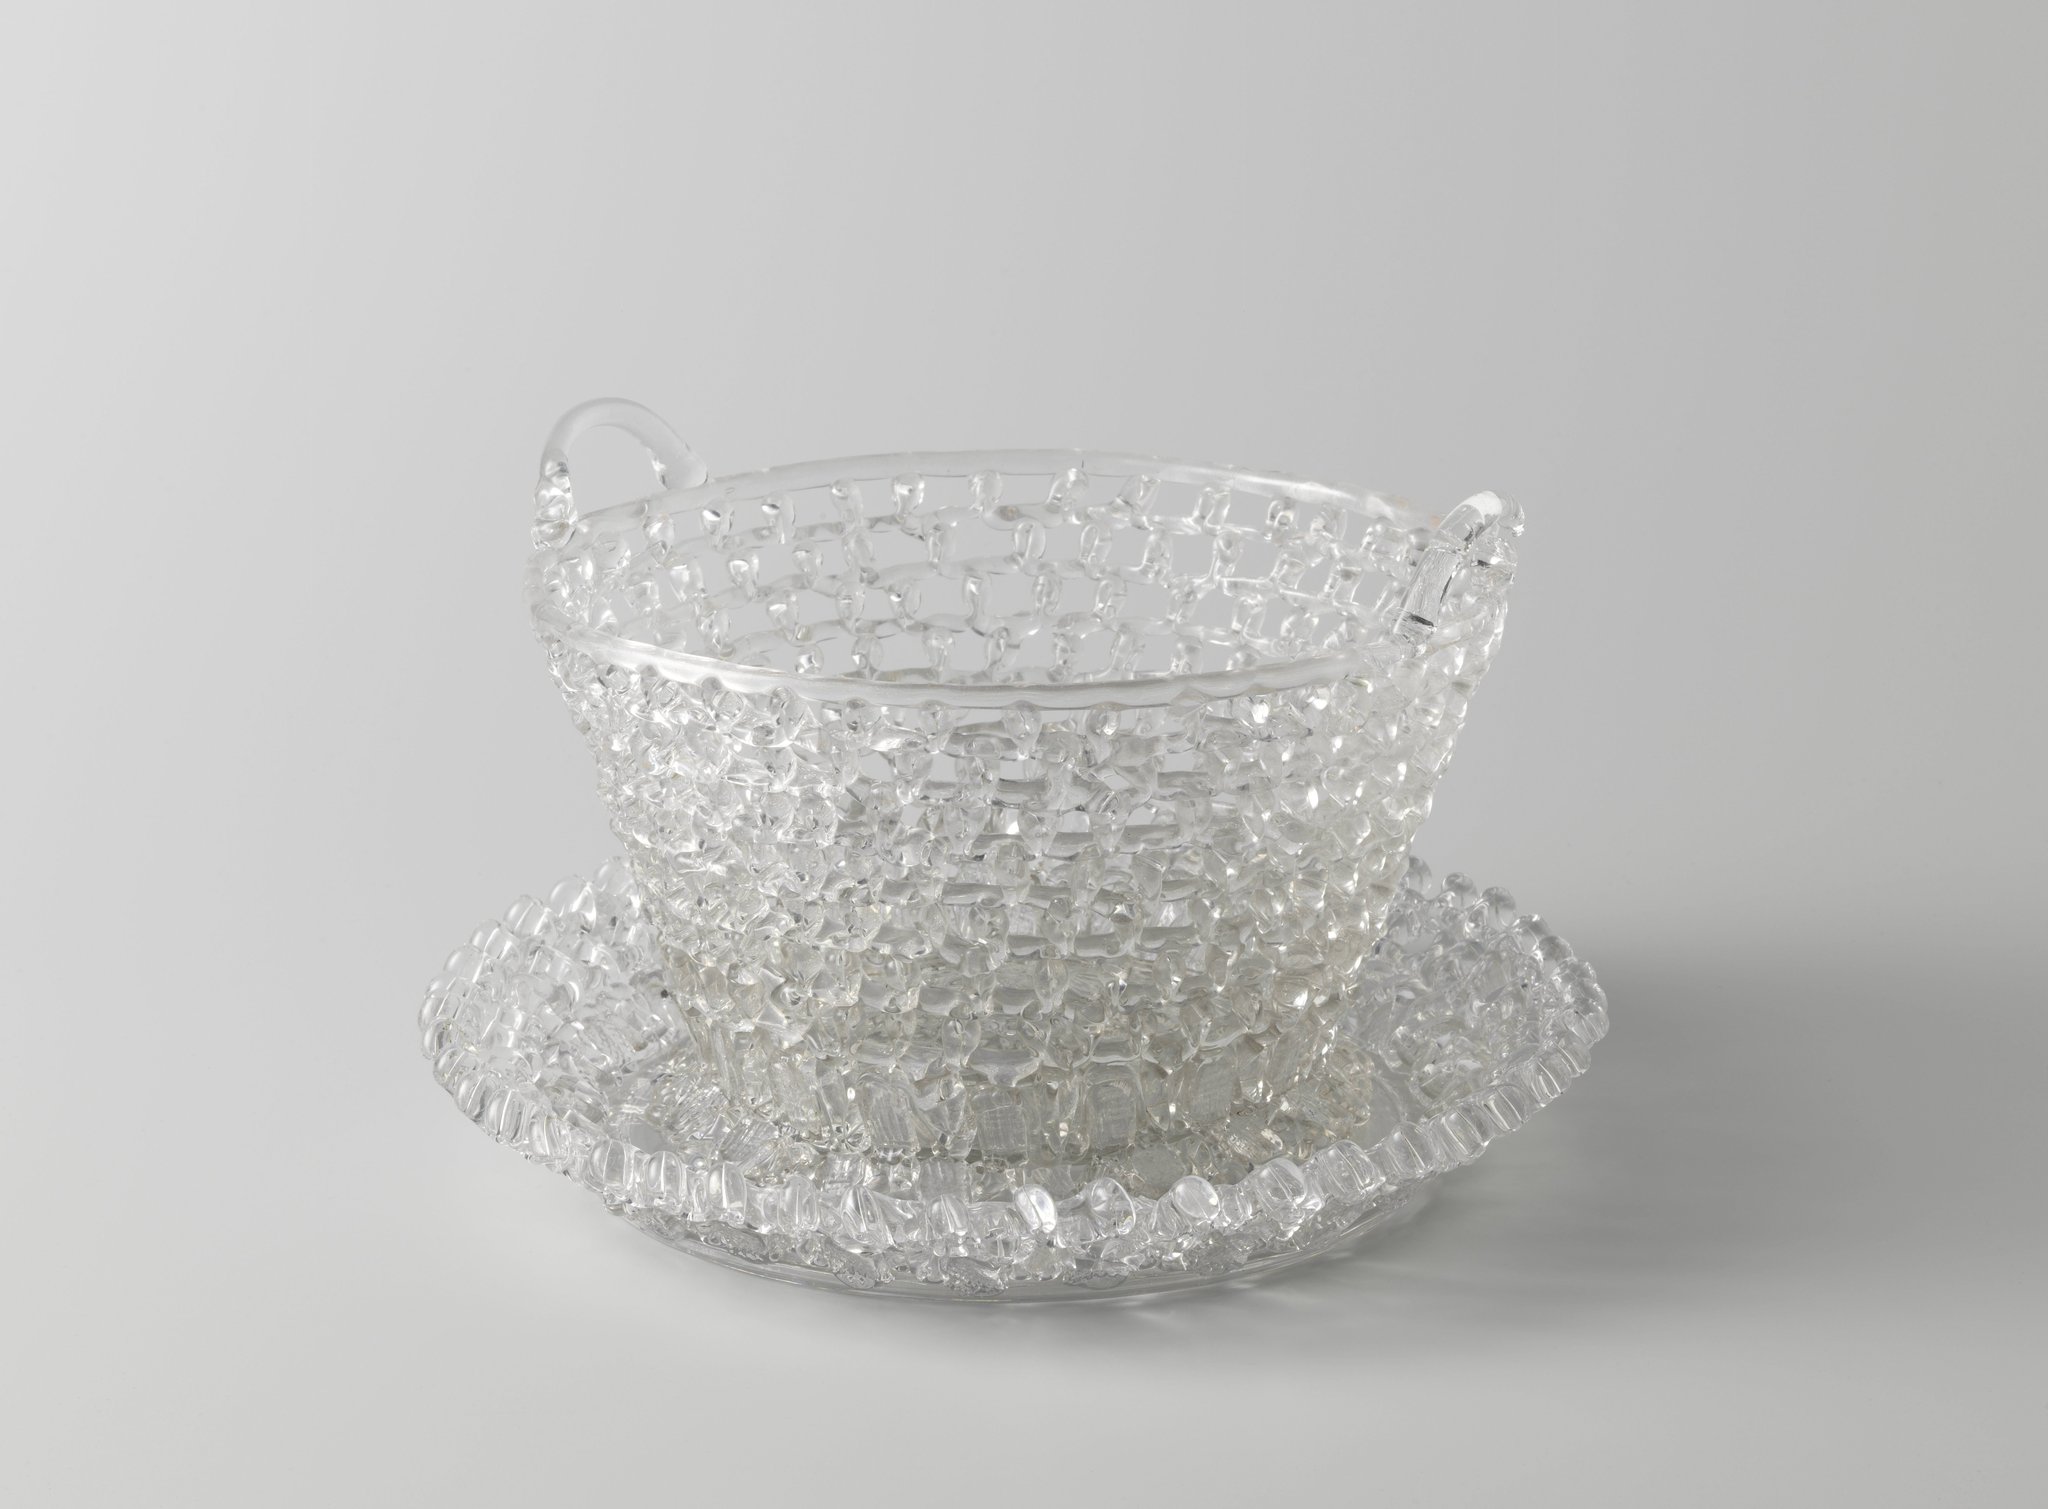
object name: sweetmeat glass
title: Mand op onderschotel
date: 1750-1800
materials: glass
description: Onderschotel: gladde bodem, opstaande rand van gladde draden in een filetpatroon, afgezet met een dikke, gekartelde draad. Mand: geschulpte standring, bodem in een honingraatmotief, uitlopende wand opgebouwd uit gladde draden in een filetpatroon. Langs de rand een gladde draad. Twee gladde, opstaande oren.